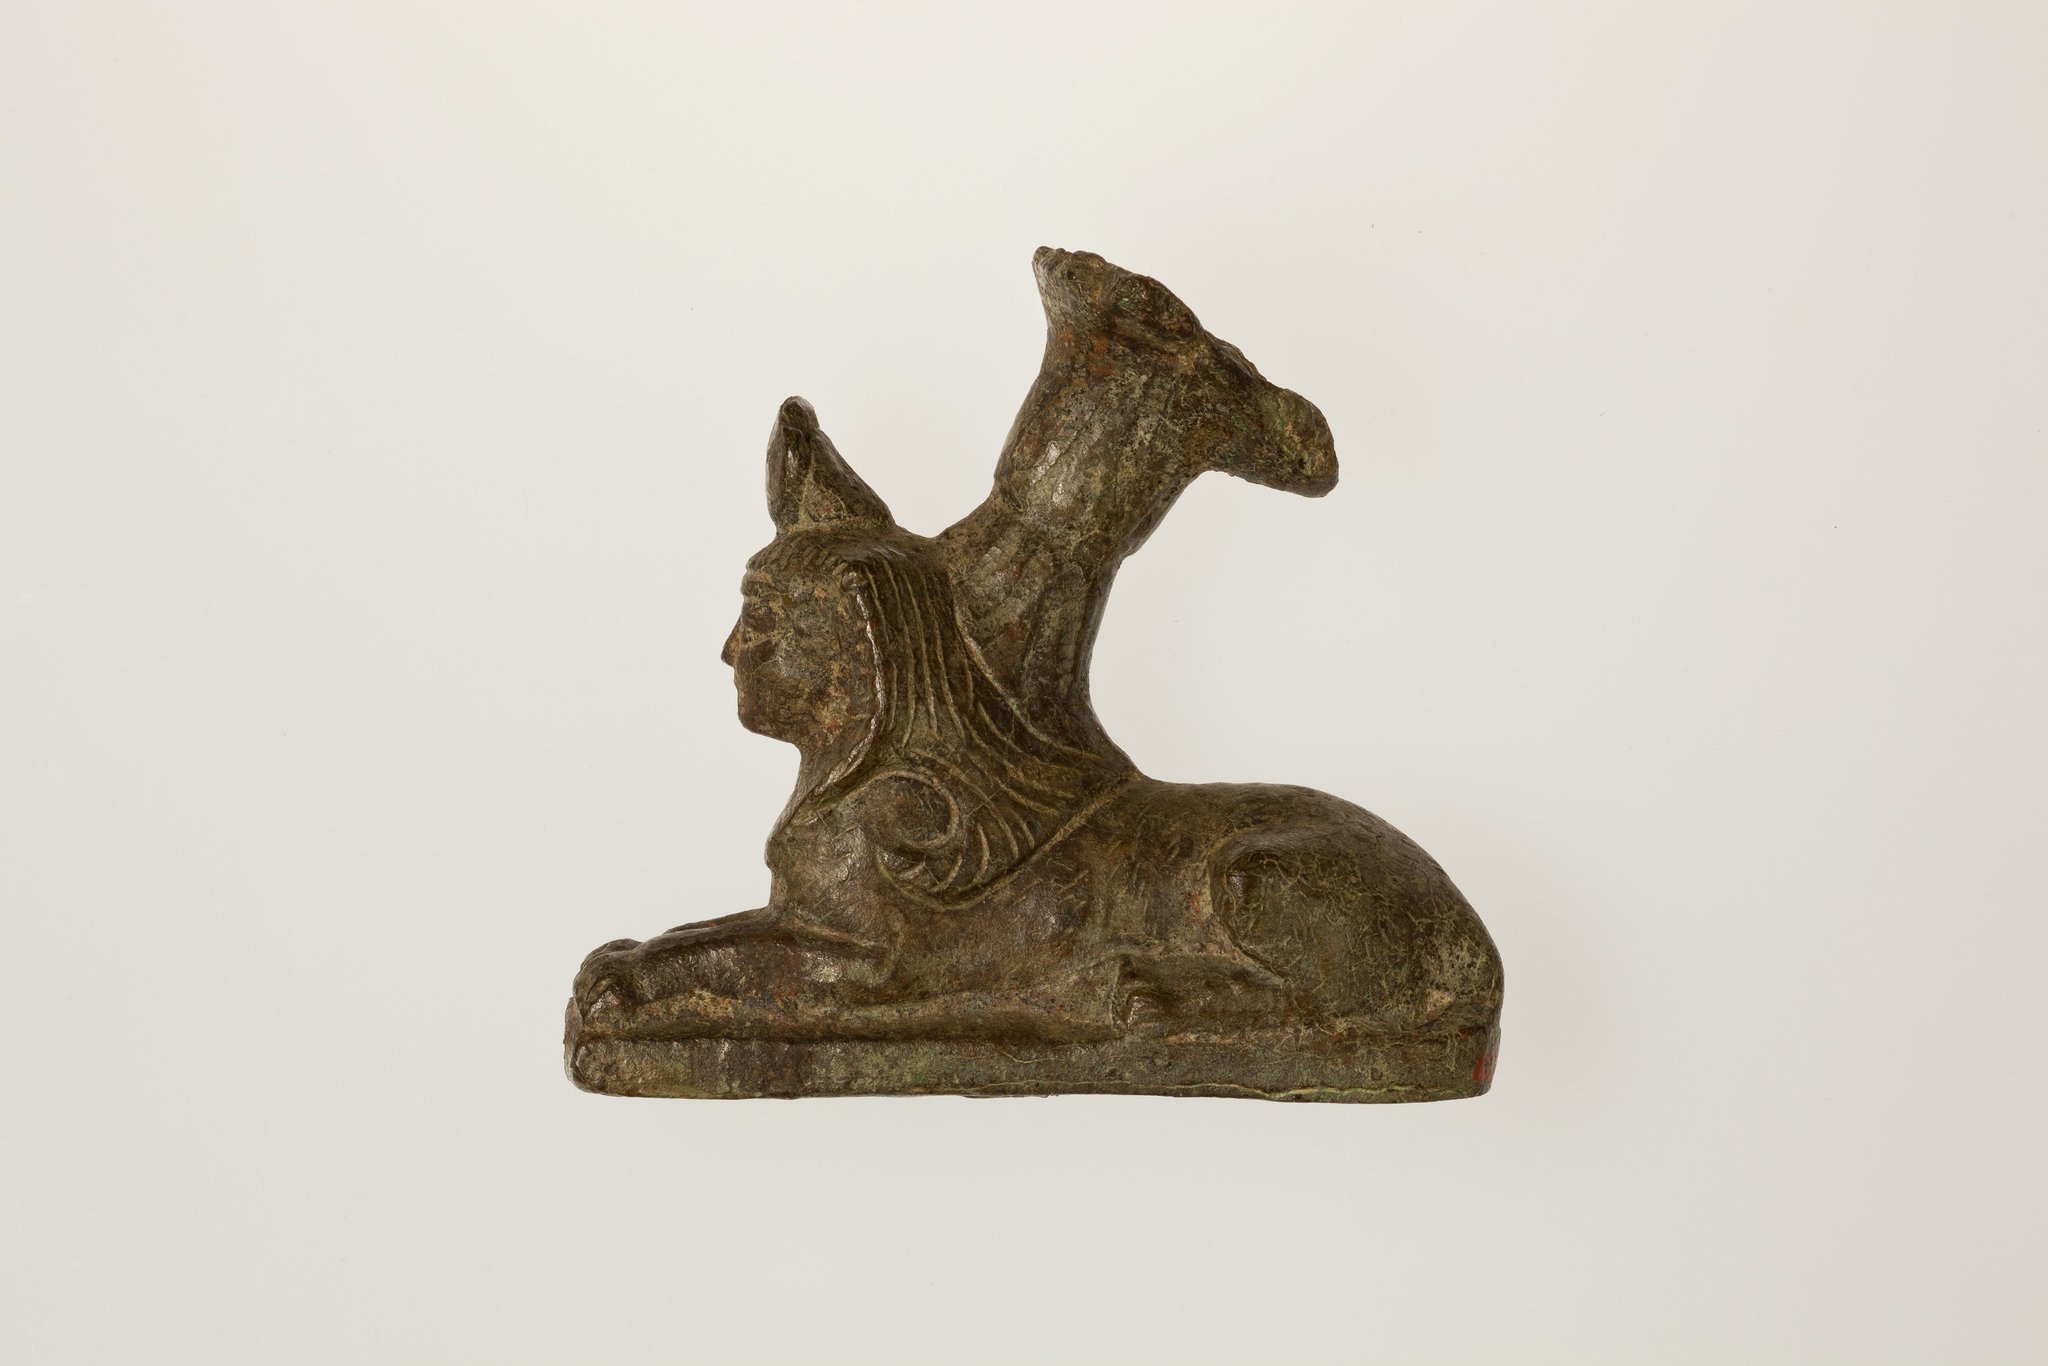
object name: sphinx, vessel foot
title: Sphinx-shaped foot of vessel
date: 150 BCE-150 CE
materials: copper alloy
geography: egypt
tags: sphinx